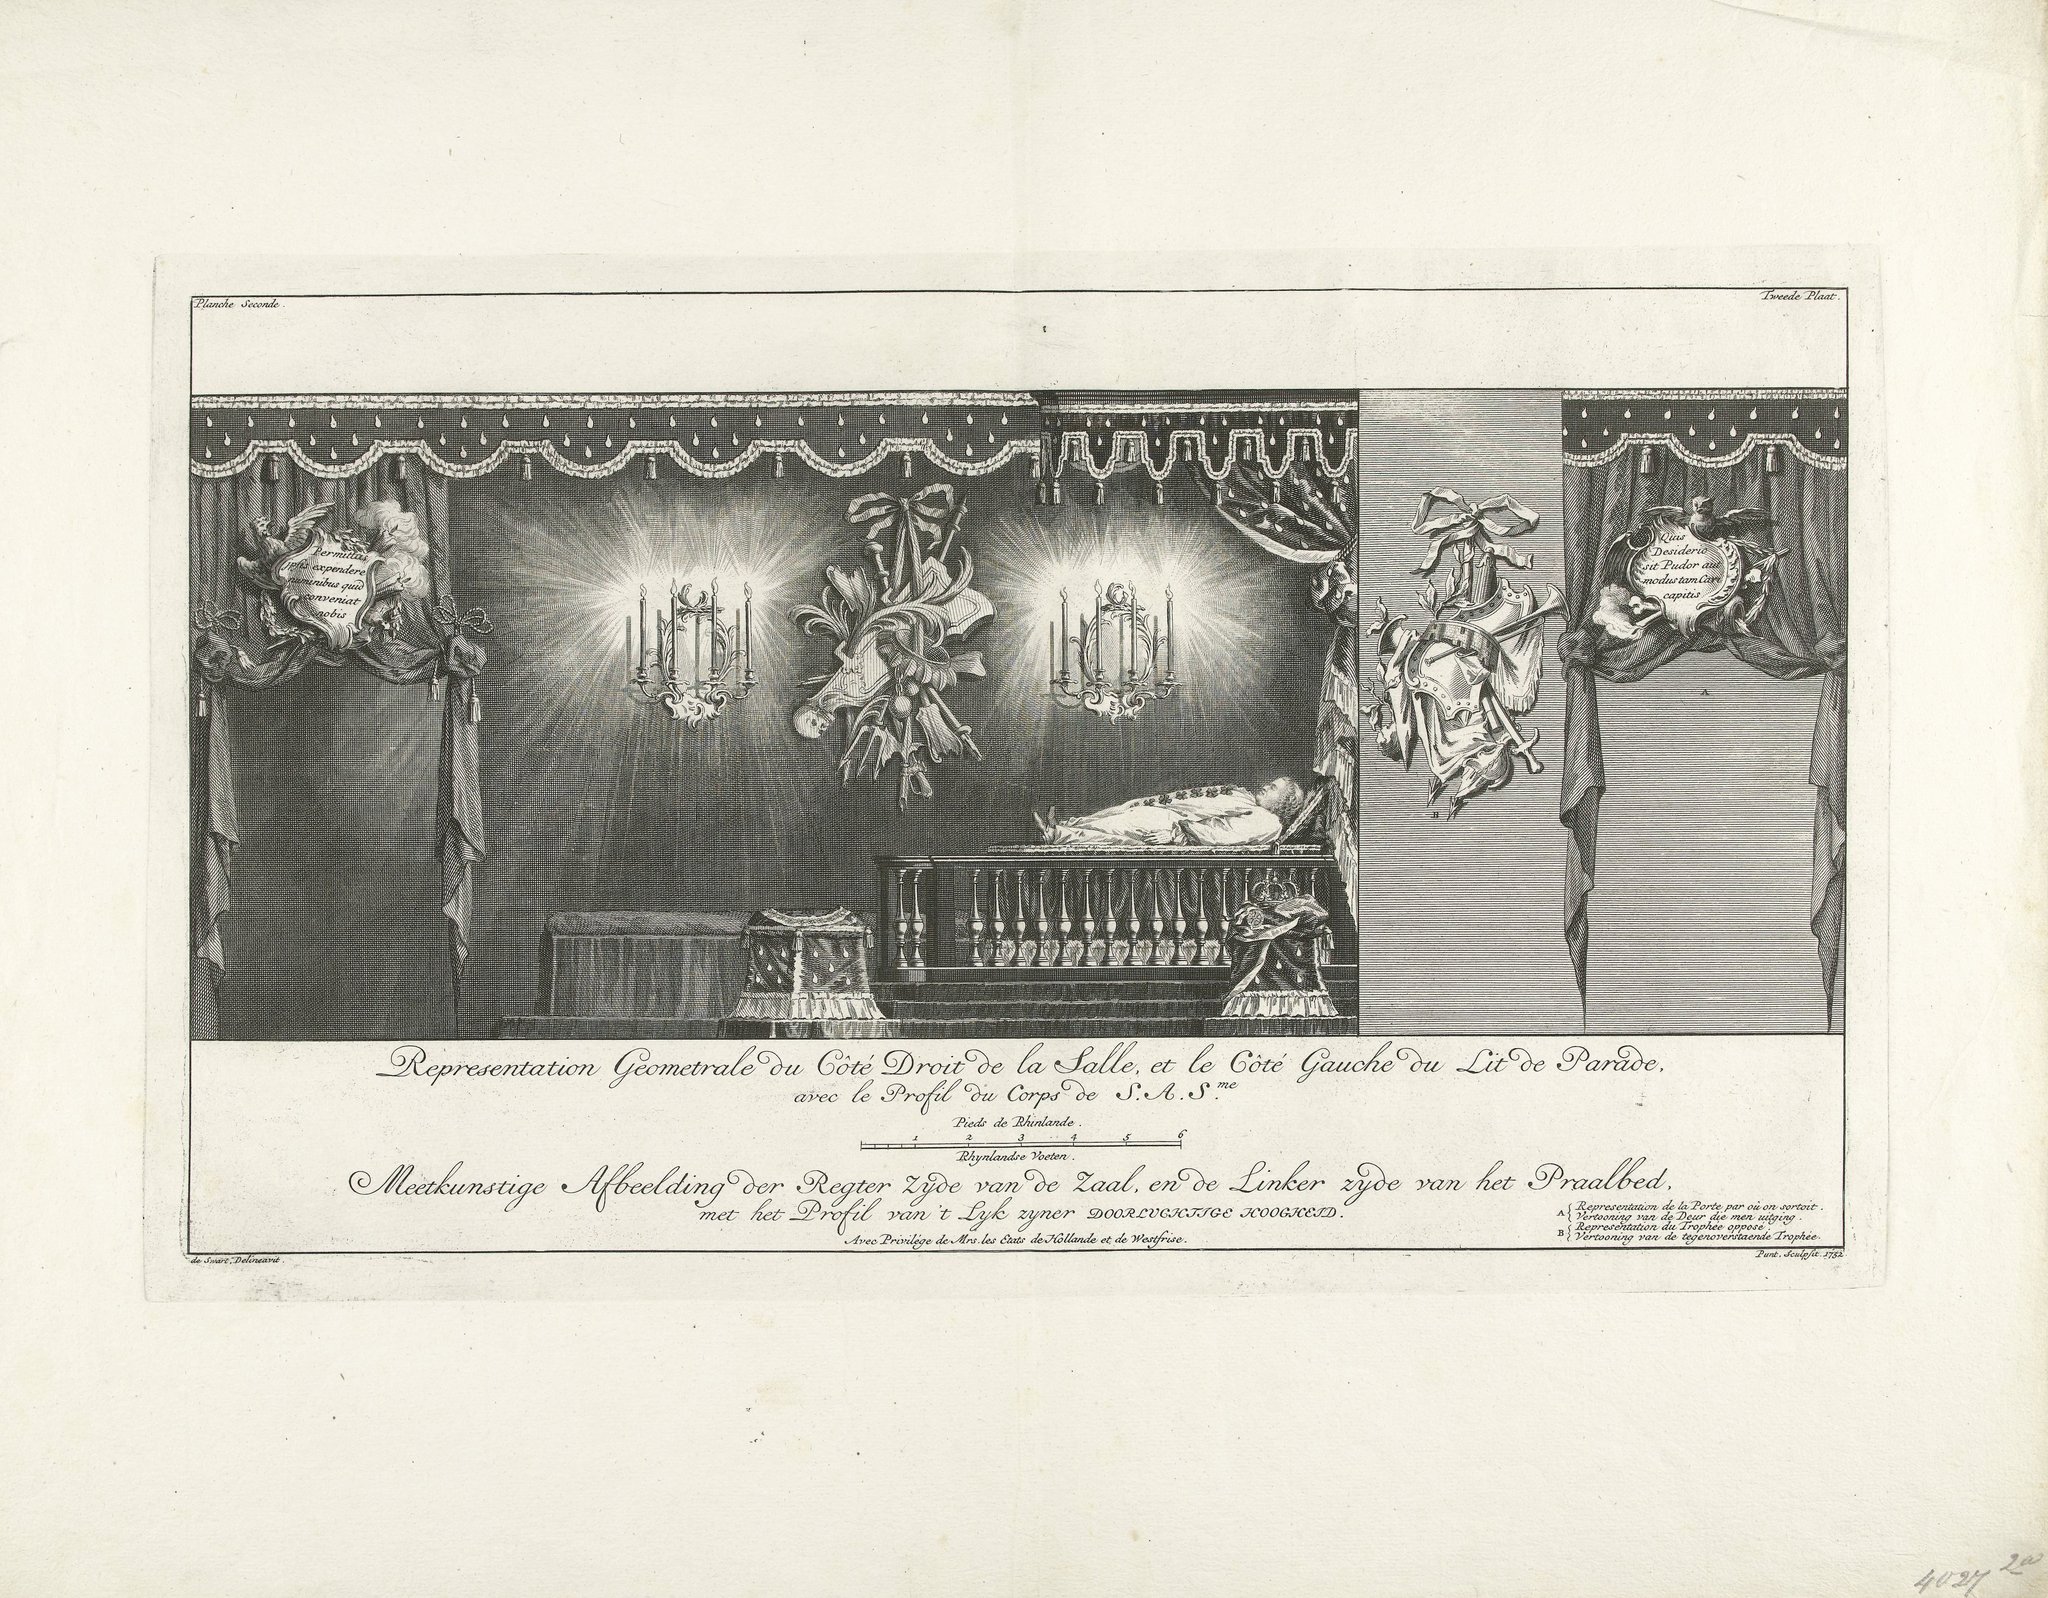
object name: print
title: Praalbed van Willem IV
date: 1752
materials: paper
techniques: engraving, etching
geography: the hague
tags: willem iv (prins van oranje-nassau), lying in state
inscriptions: collector's mark: Lugt 2228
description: Rechterzijde van de zaal met het praalbed met het lichaam van prins Willem IV. Onderdeel van de serie van vier platen van het praalbed waarop de op 22 oktober overleden prins Willem IV gedurende de maanden november en december van het jaar 1751 opgebaard heeft gelegen.